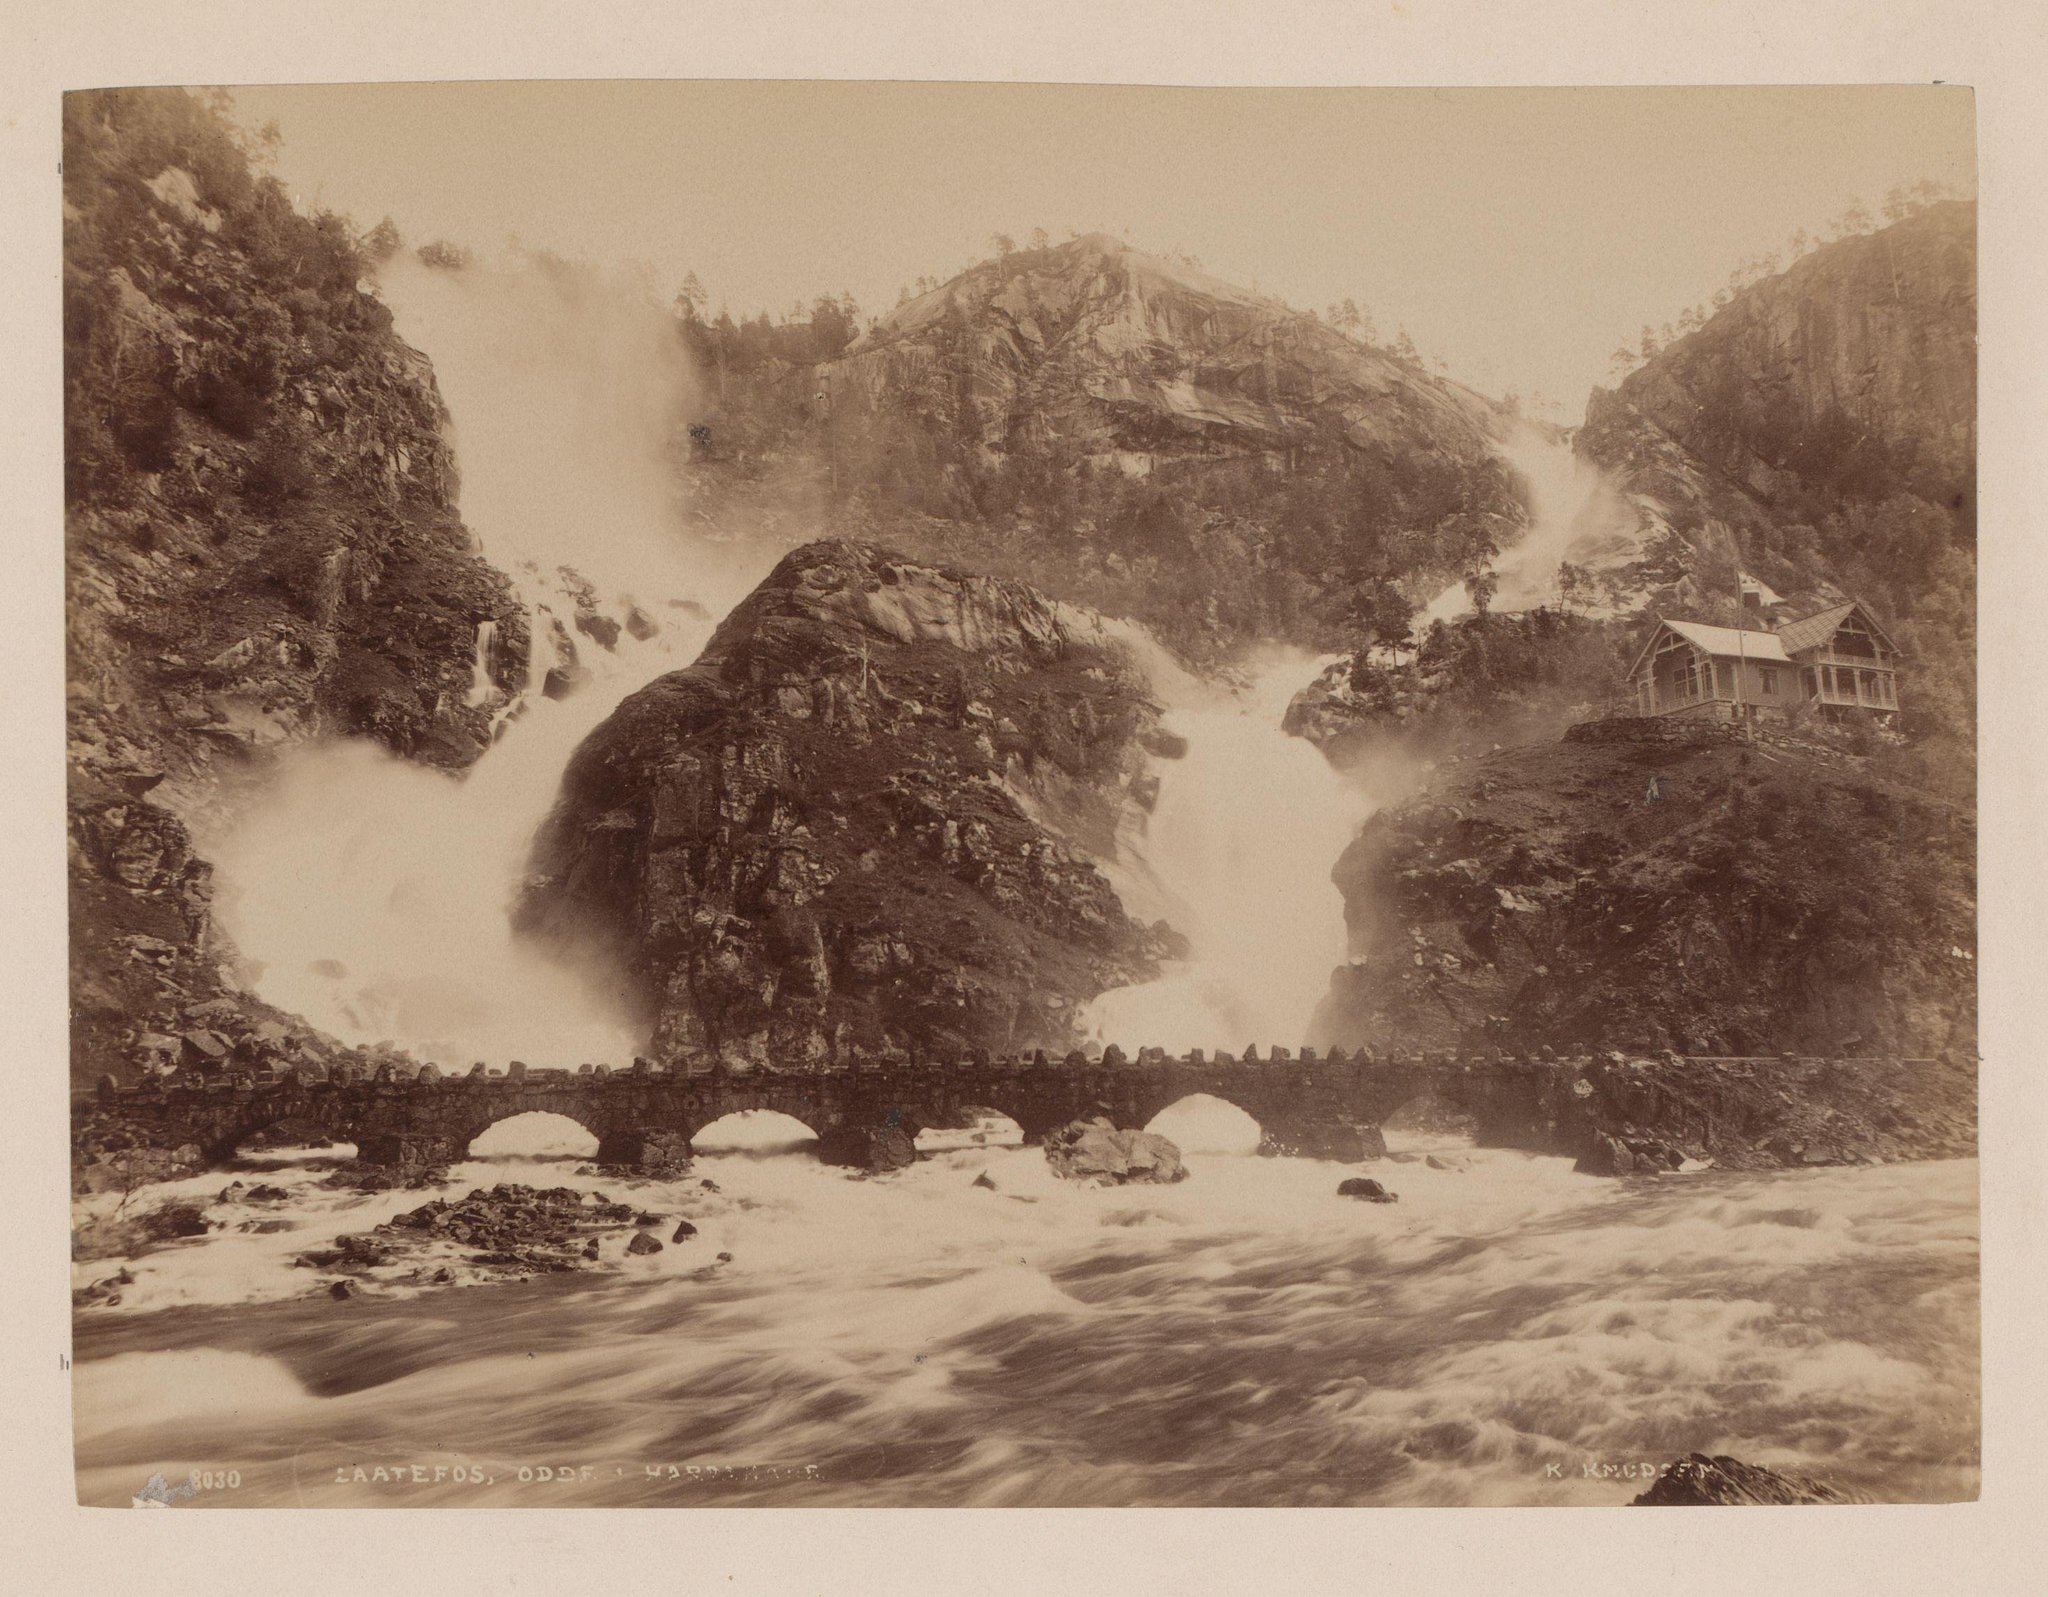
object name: photograph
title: Laatefos, Hardanger, Noorwegen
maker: knud knudsen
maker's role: fotograaf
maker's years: 1832-1915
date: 1880-1900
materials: cardboard, photographic support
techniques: albumen print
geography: norway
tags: norway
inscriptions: caption: ‘8030. LAATEFOS. ODDF [?] HARDANGER’, inscription: ‘K. KNUDSEN [...]’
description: Twee woeste rivieren stromen vanaf een berg samen in een grote rivier op de voorgrond, Hardanger, Noorwegen. Foto zit samen met RP-F-00-6406-2 op één karton geplakt.